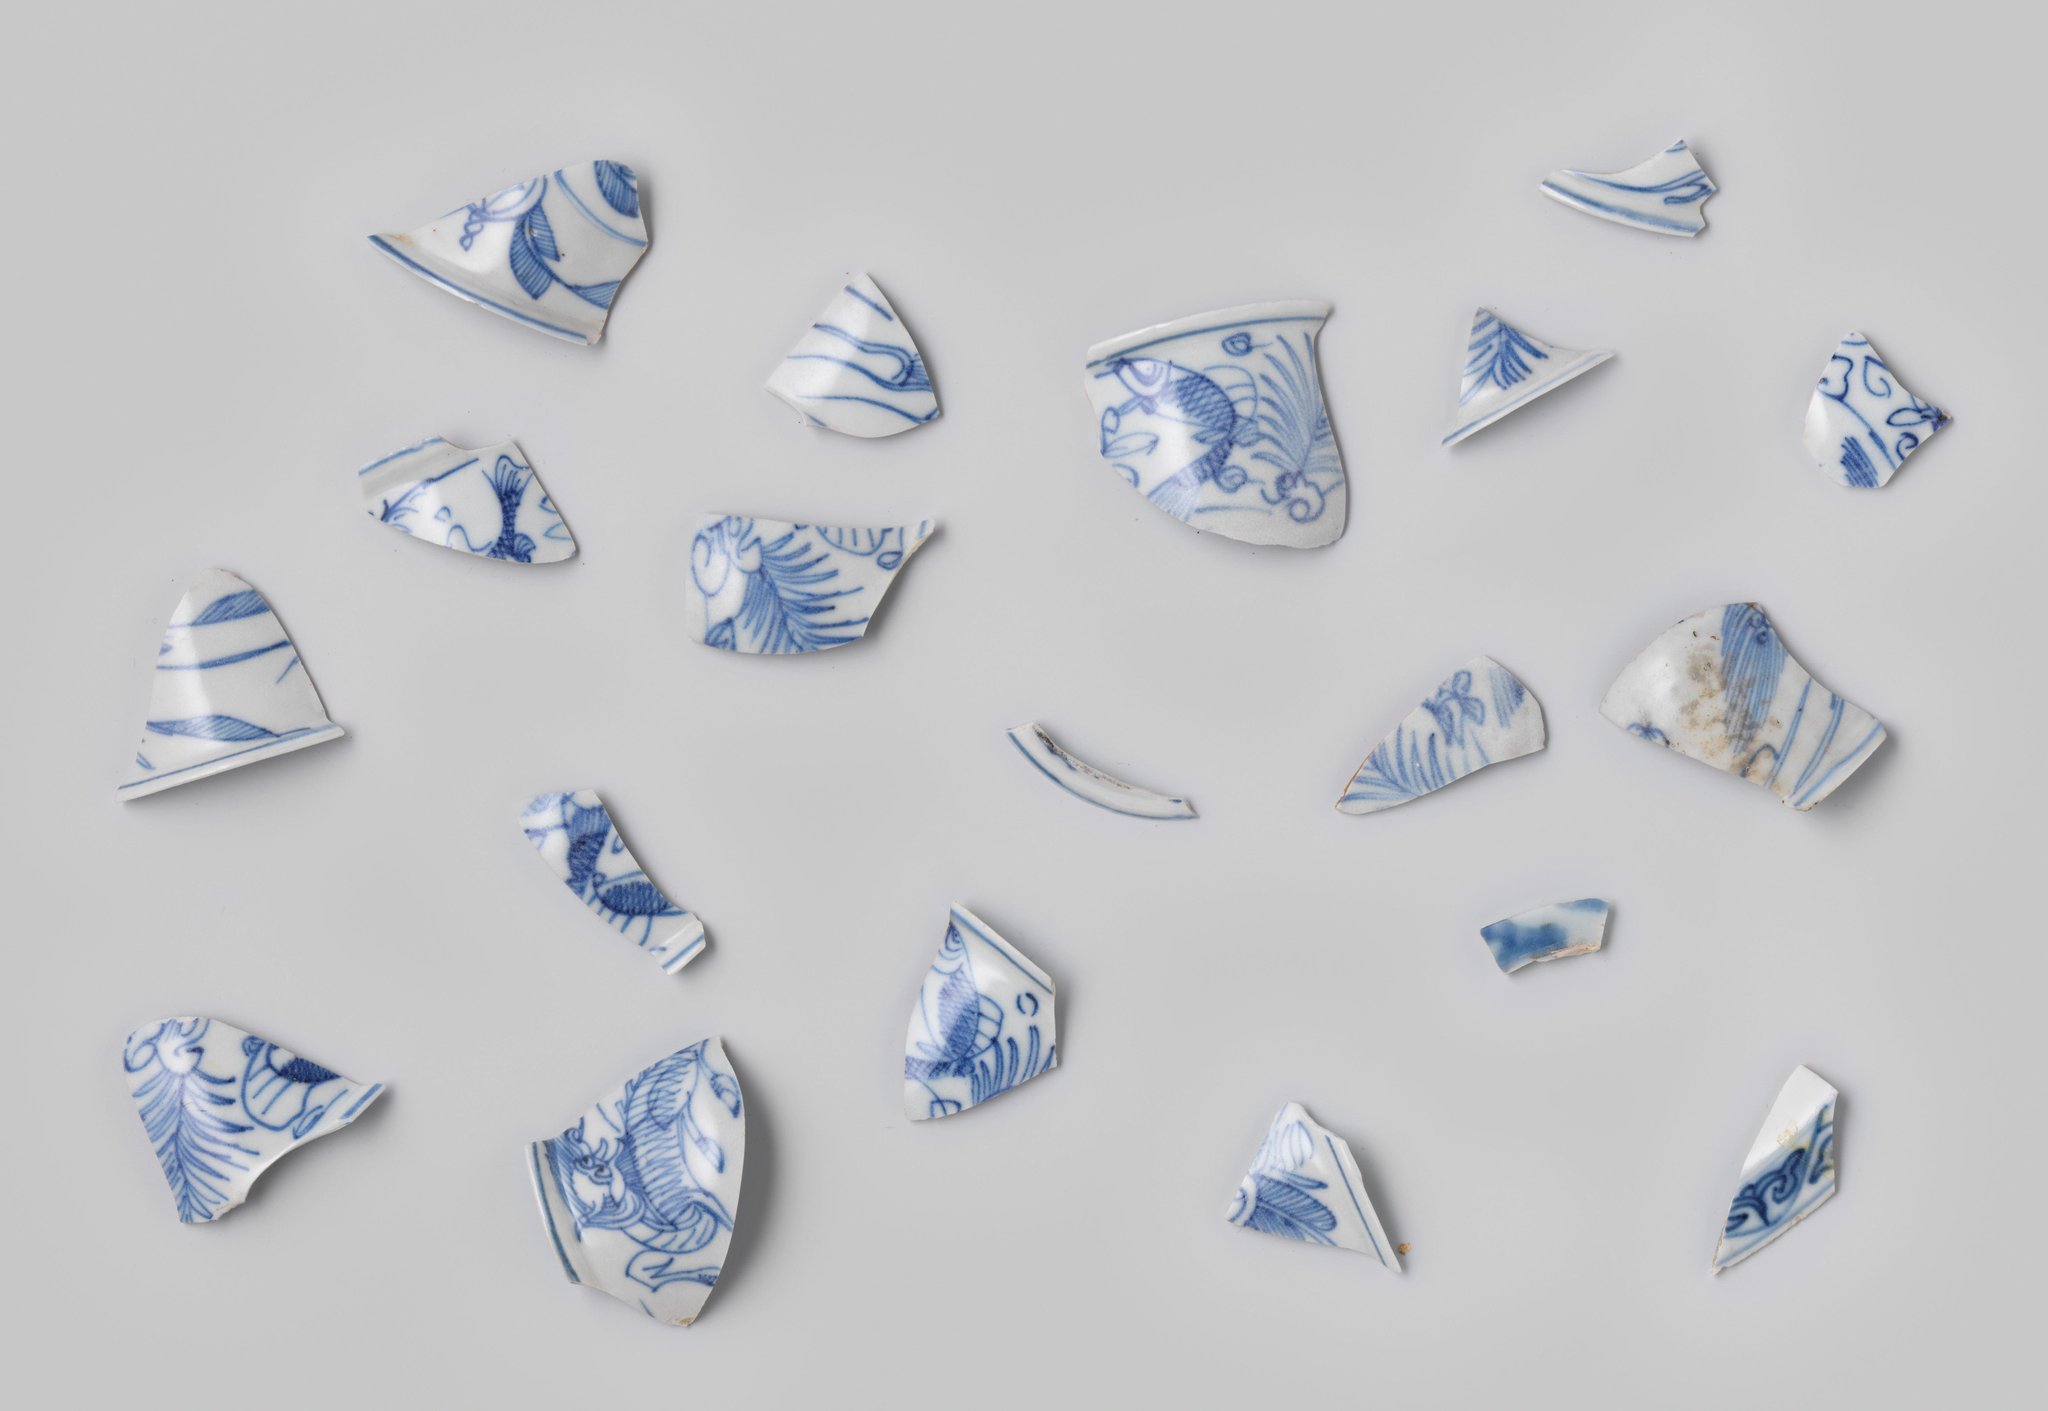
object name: bowl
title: Scherven van kommen uit V.O.C.-schip de 'Witte Leeuw'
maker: Anonymous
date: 1613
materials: porcelain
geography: jingdezhen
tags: verenigde oostindische compagnie, sint-helena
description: A tea bowl. The cobalt blue is of a very light blue. In the centre a very sketchy design is drawn, encircled by two thin bands. There is no decoration on the walls. On the outside four carps are sketchily drawn in various poses among waterweed and flowers.